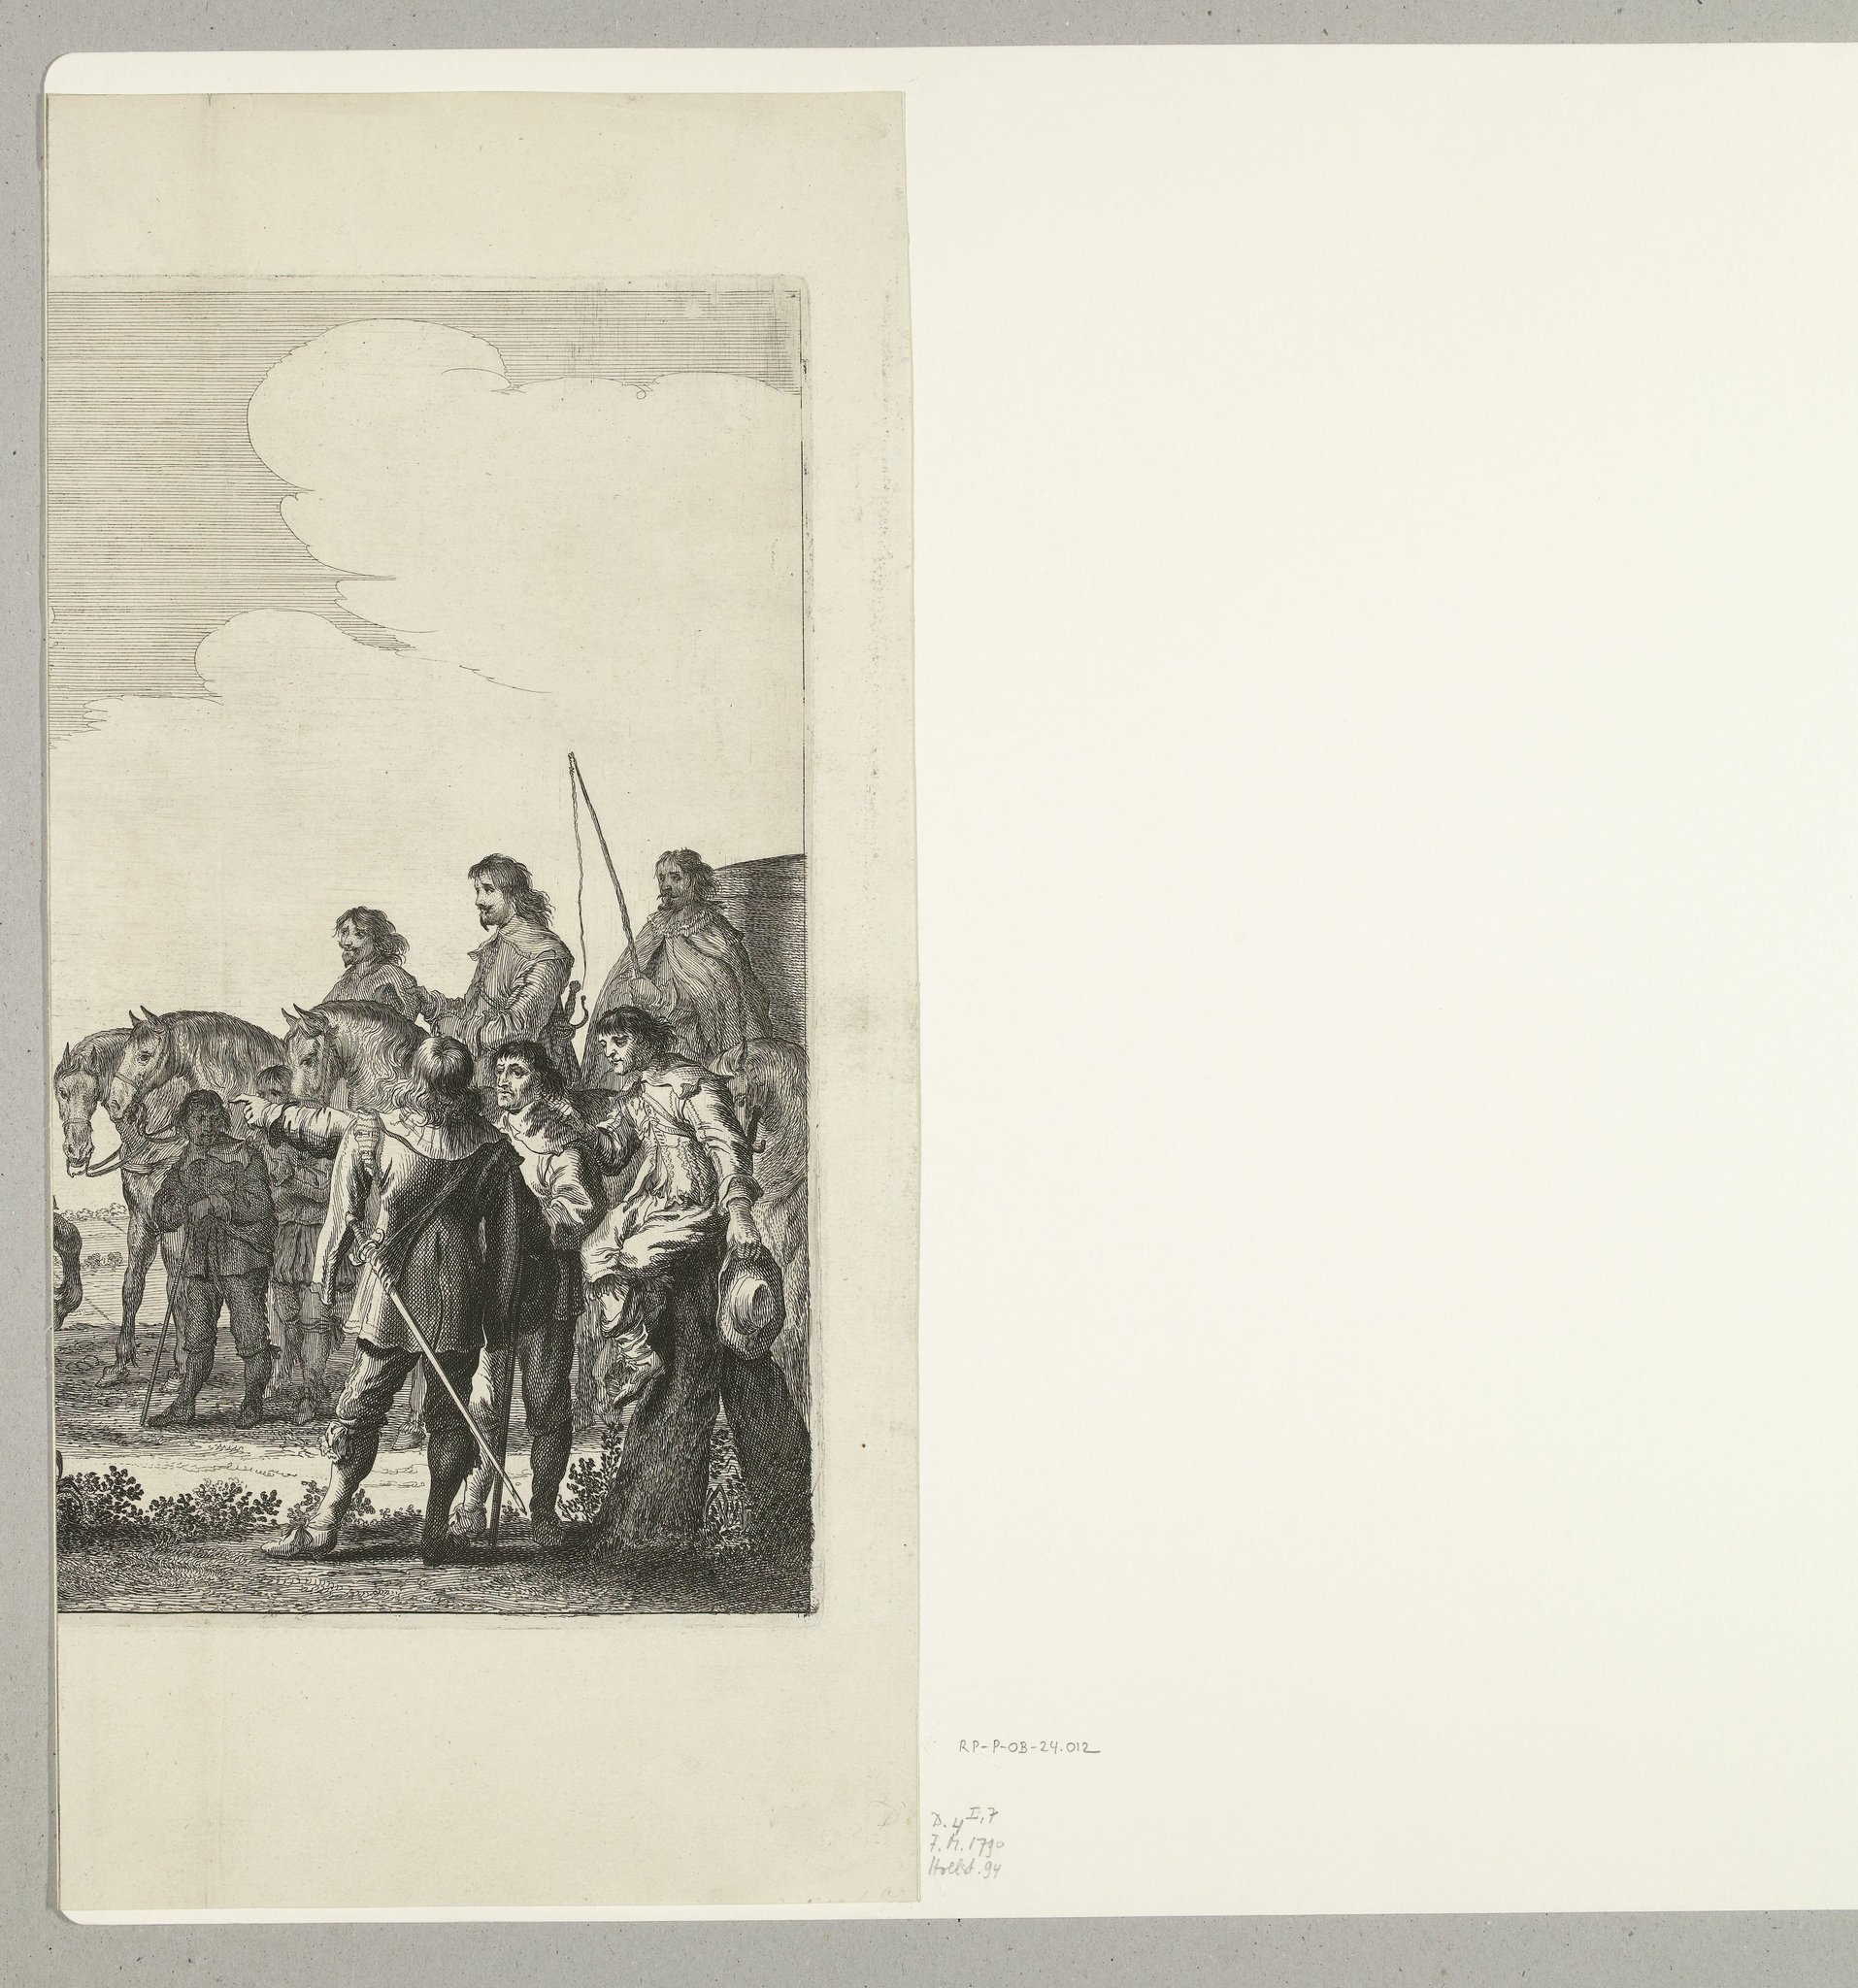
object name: print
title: Intocht van Maria de Médicis te Amsterdam (plaat 7), 1638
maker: pieter nolpe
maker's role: draughtsman, print maker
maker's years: 1613-1653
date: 1638-1639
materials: paper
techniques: engraving, etching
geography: northern netherlands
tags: cologne, maria de' medici, triumphal entry and public reception, pageant, 'entrée solennelle', 'joyeuse entrée', amsterdam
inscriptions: collector's mark: Lugt 2228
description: Intocht van de Franse koningin Maria de Médicis te Amsterdam, 31 augustus 1638. Zevende plaat in een ongemonteerd ensemble bestaande uit een titelblad, een portret en zeven bladen van de stoet. Kleine plaat met het laatste deel van de stoet met enkele ruiters en een deel van een tweede wagen.